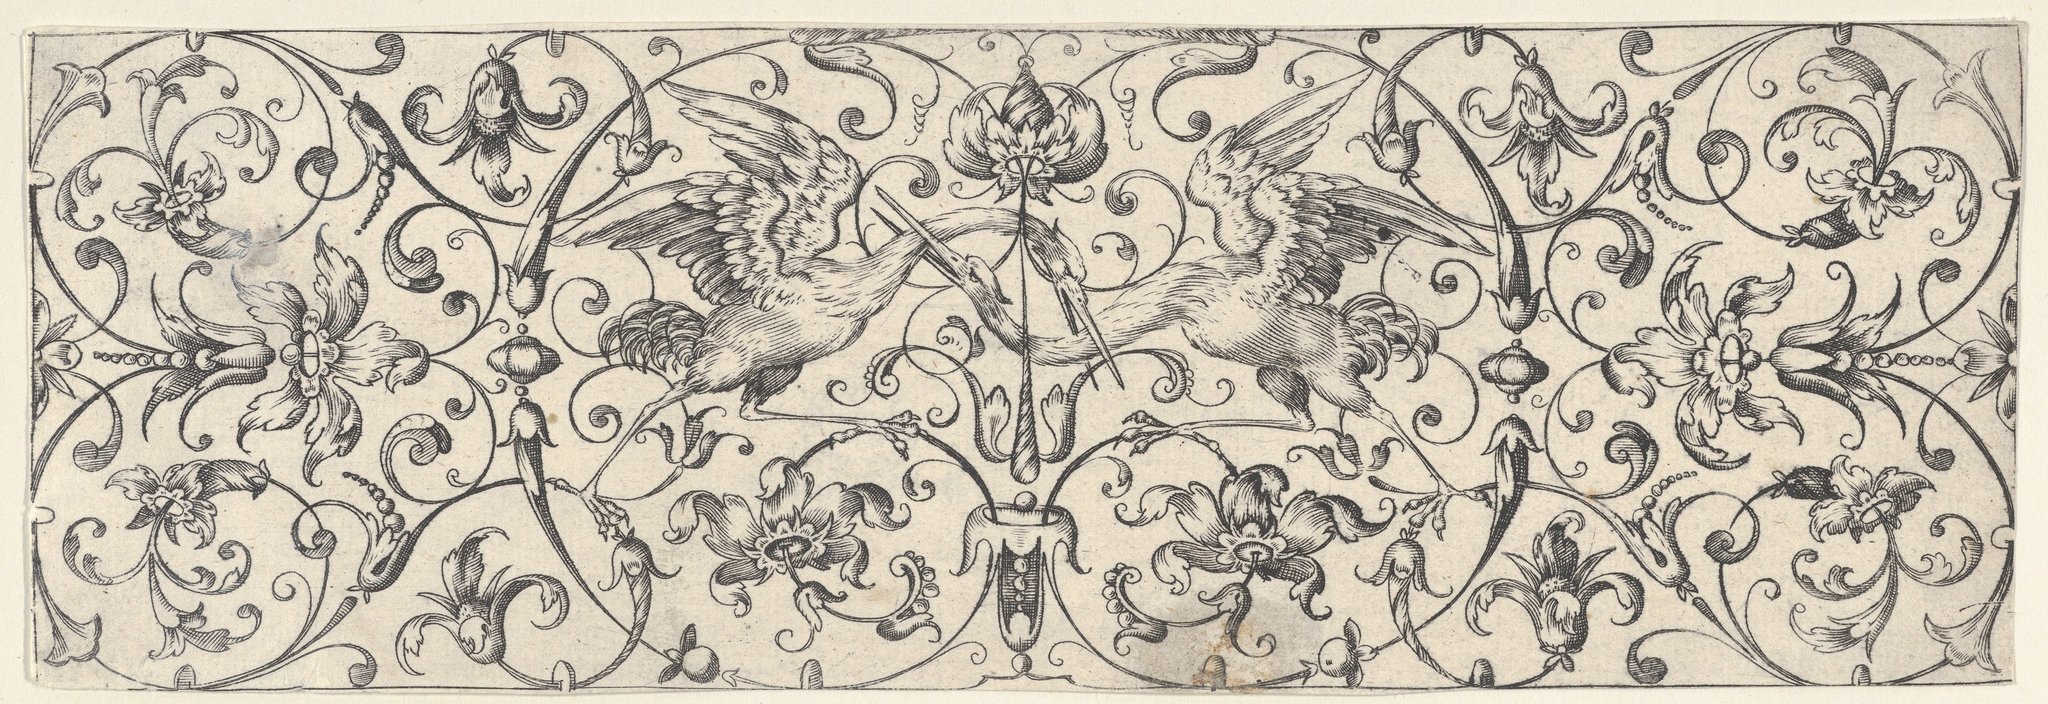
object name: ornament architecture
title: Plate 3, from "Friezes with Birds, Flowers and Meandering Wreaths and Scrolls"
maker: theodor bang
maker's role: artist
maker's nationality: german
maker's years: 1606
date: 1600-1617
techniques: etching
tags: birds,ornament